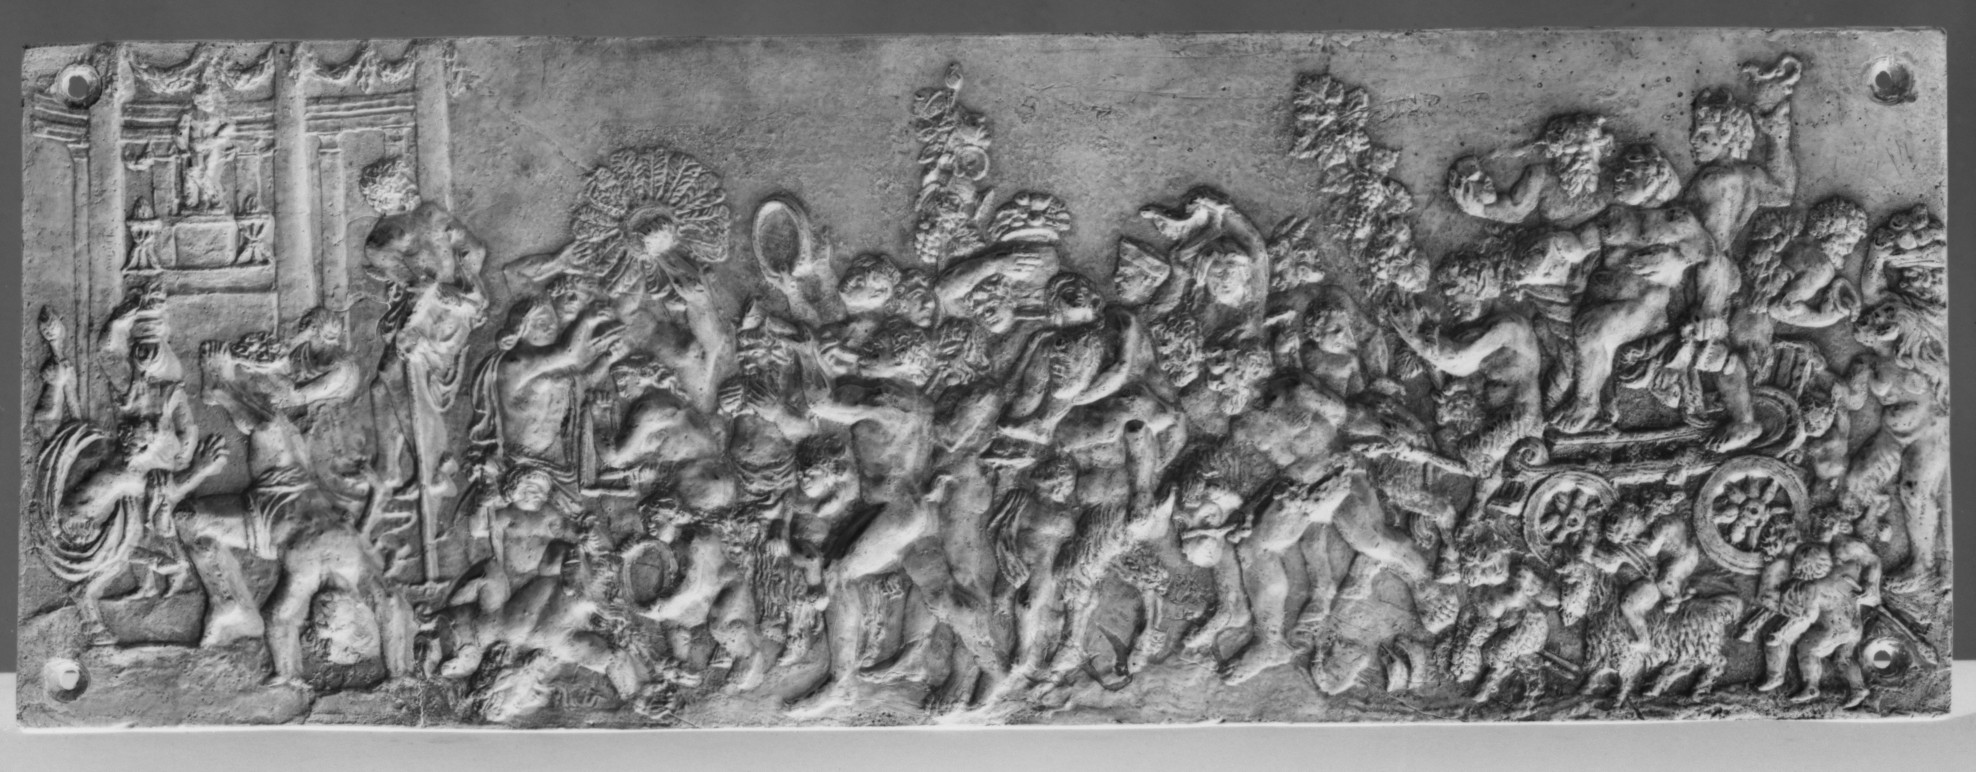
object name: relief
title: The Triumph of Silenus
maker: cornelis bos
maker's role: artist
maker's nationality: netherlandish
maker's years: 1510-1556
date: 1567-1633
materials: lead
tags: silenus,crowd